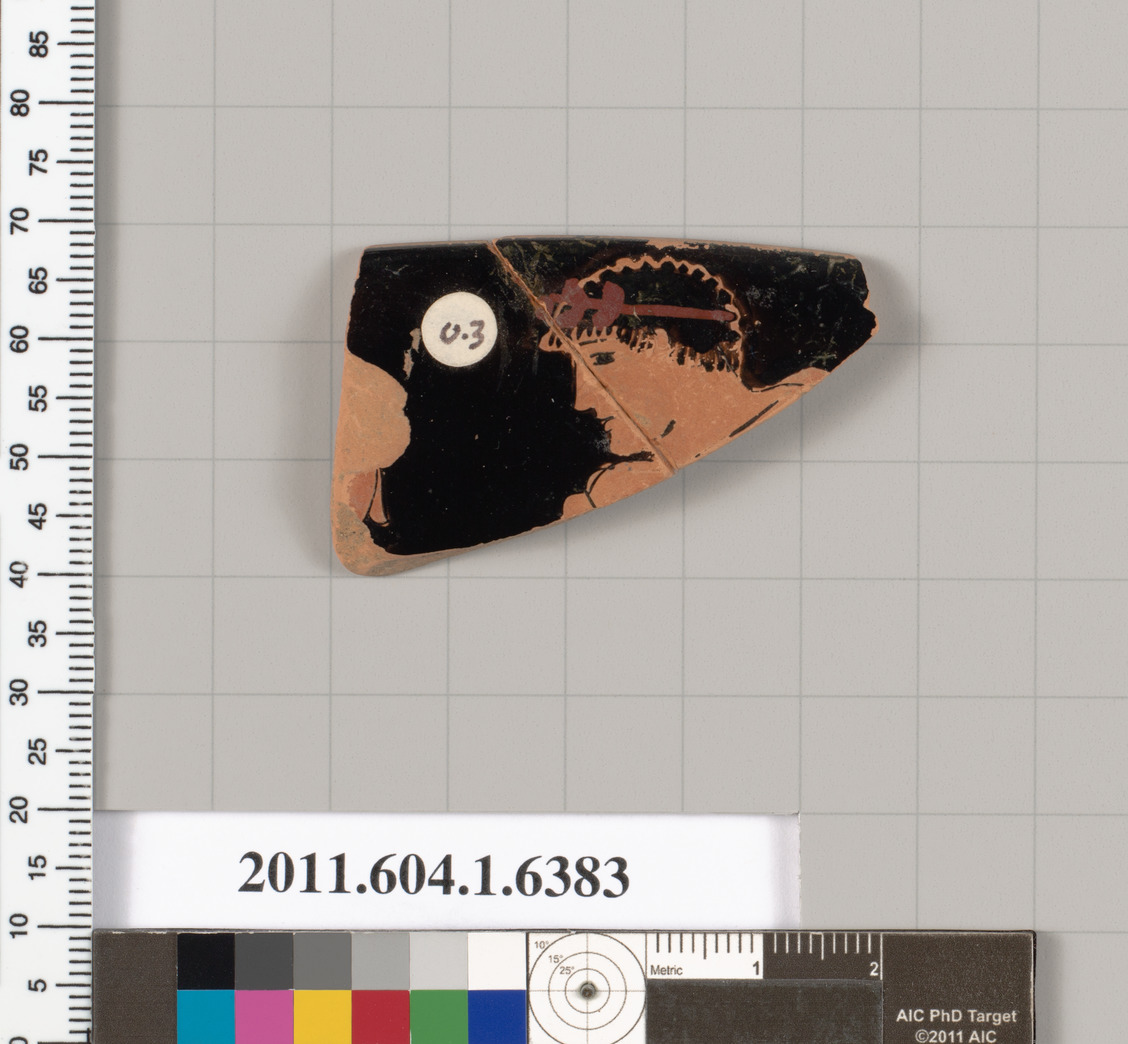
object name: kylix fragment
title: Terracotta rim fragment of a kylix (drinking cup)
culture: greek, attic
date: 490-480 BCE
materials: terracotta